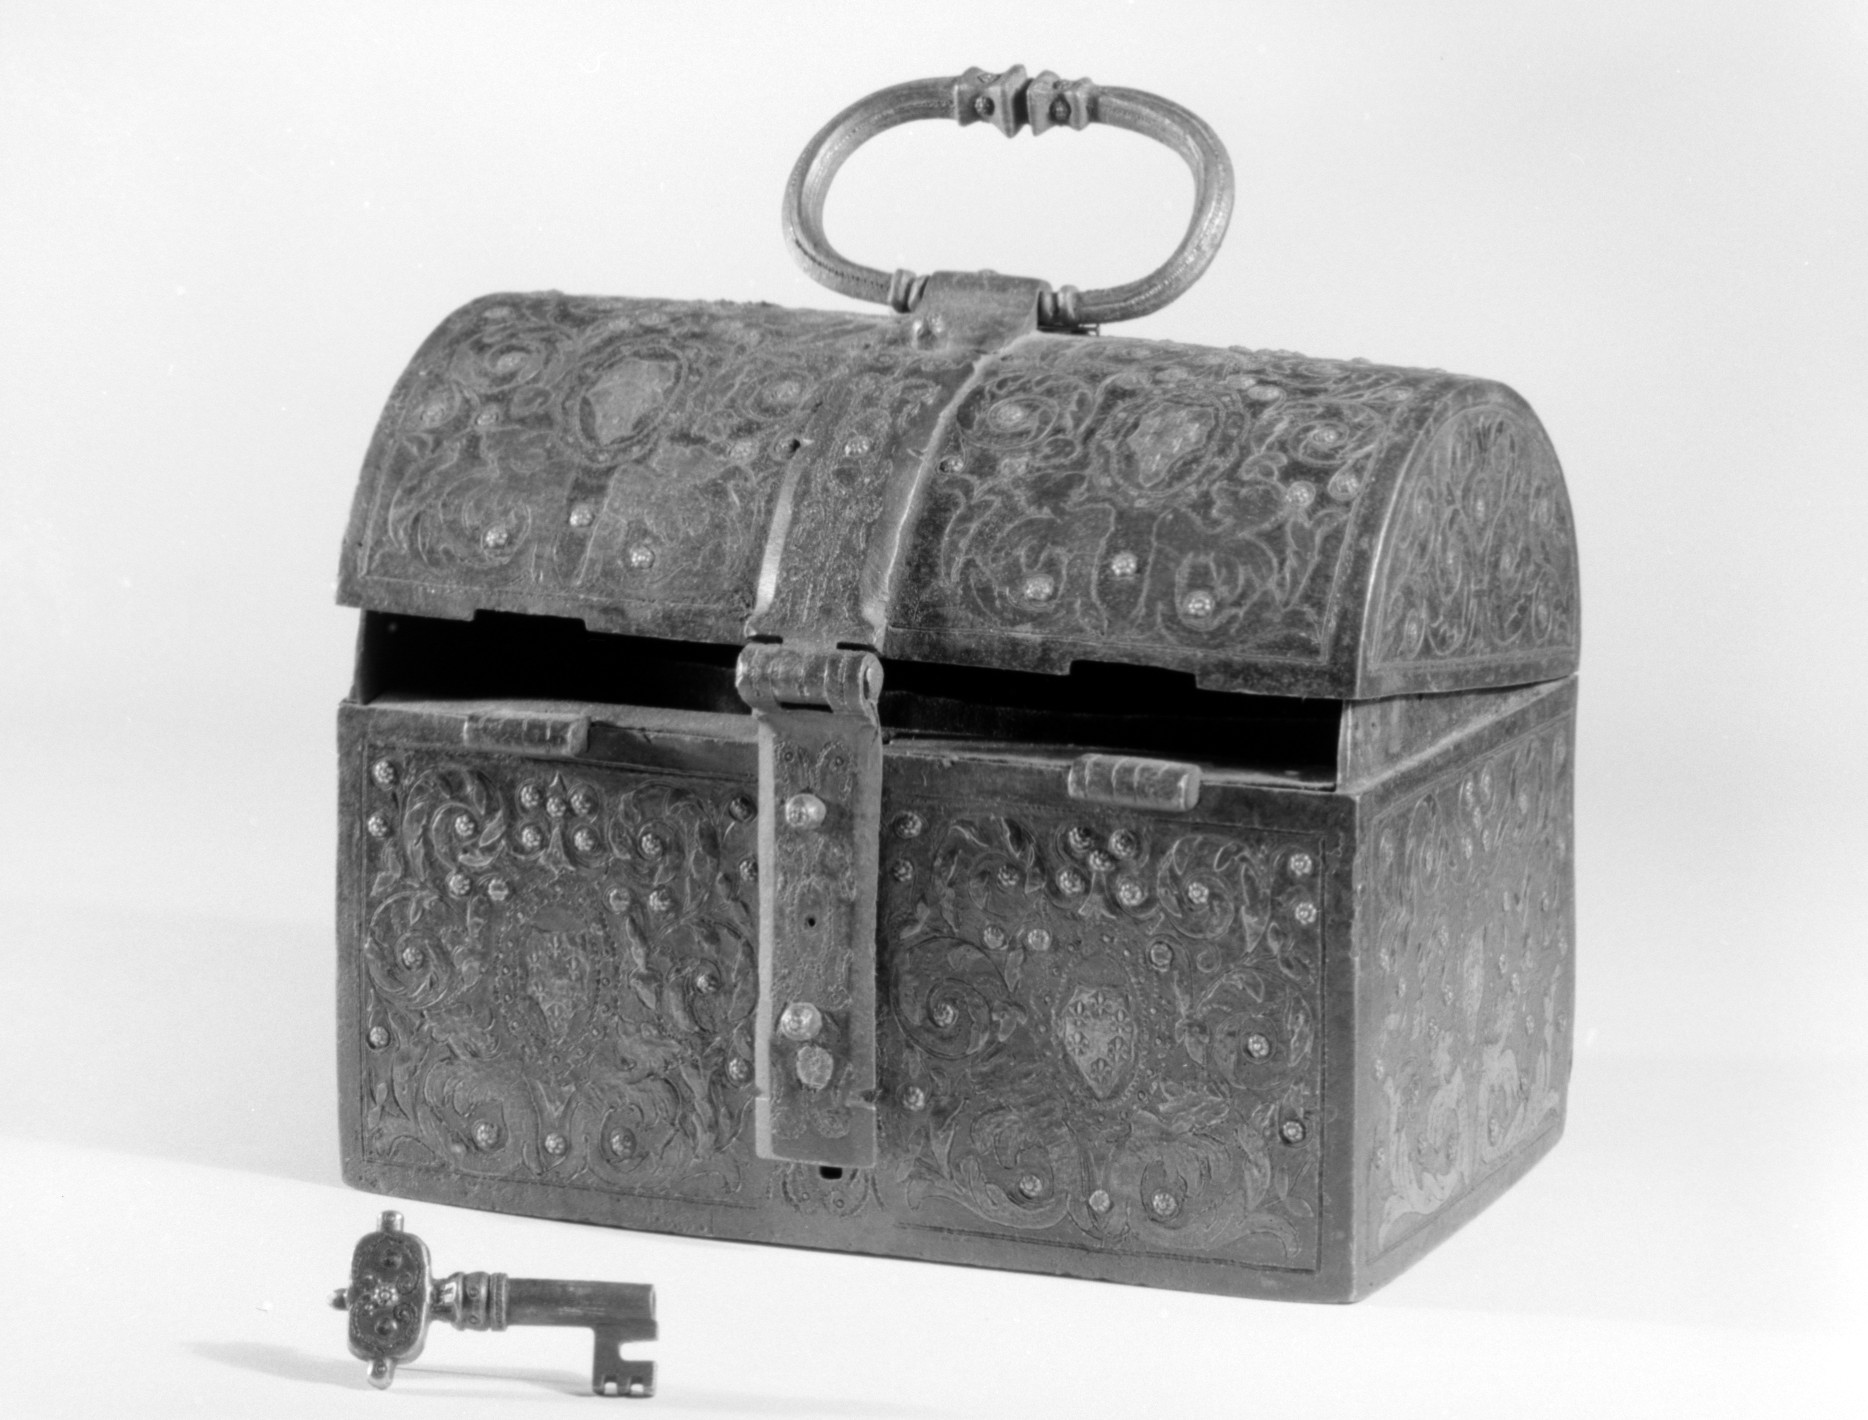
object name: casket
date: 1567-1600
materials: gold, iron